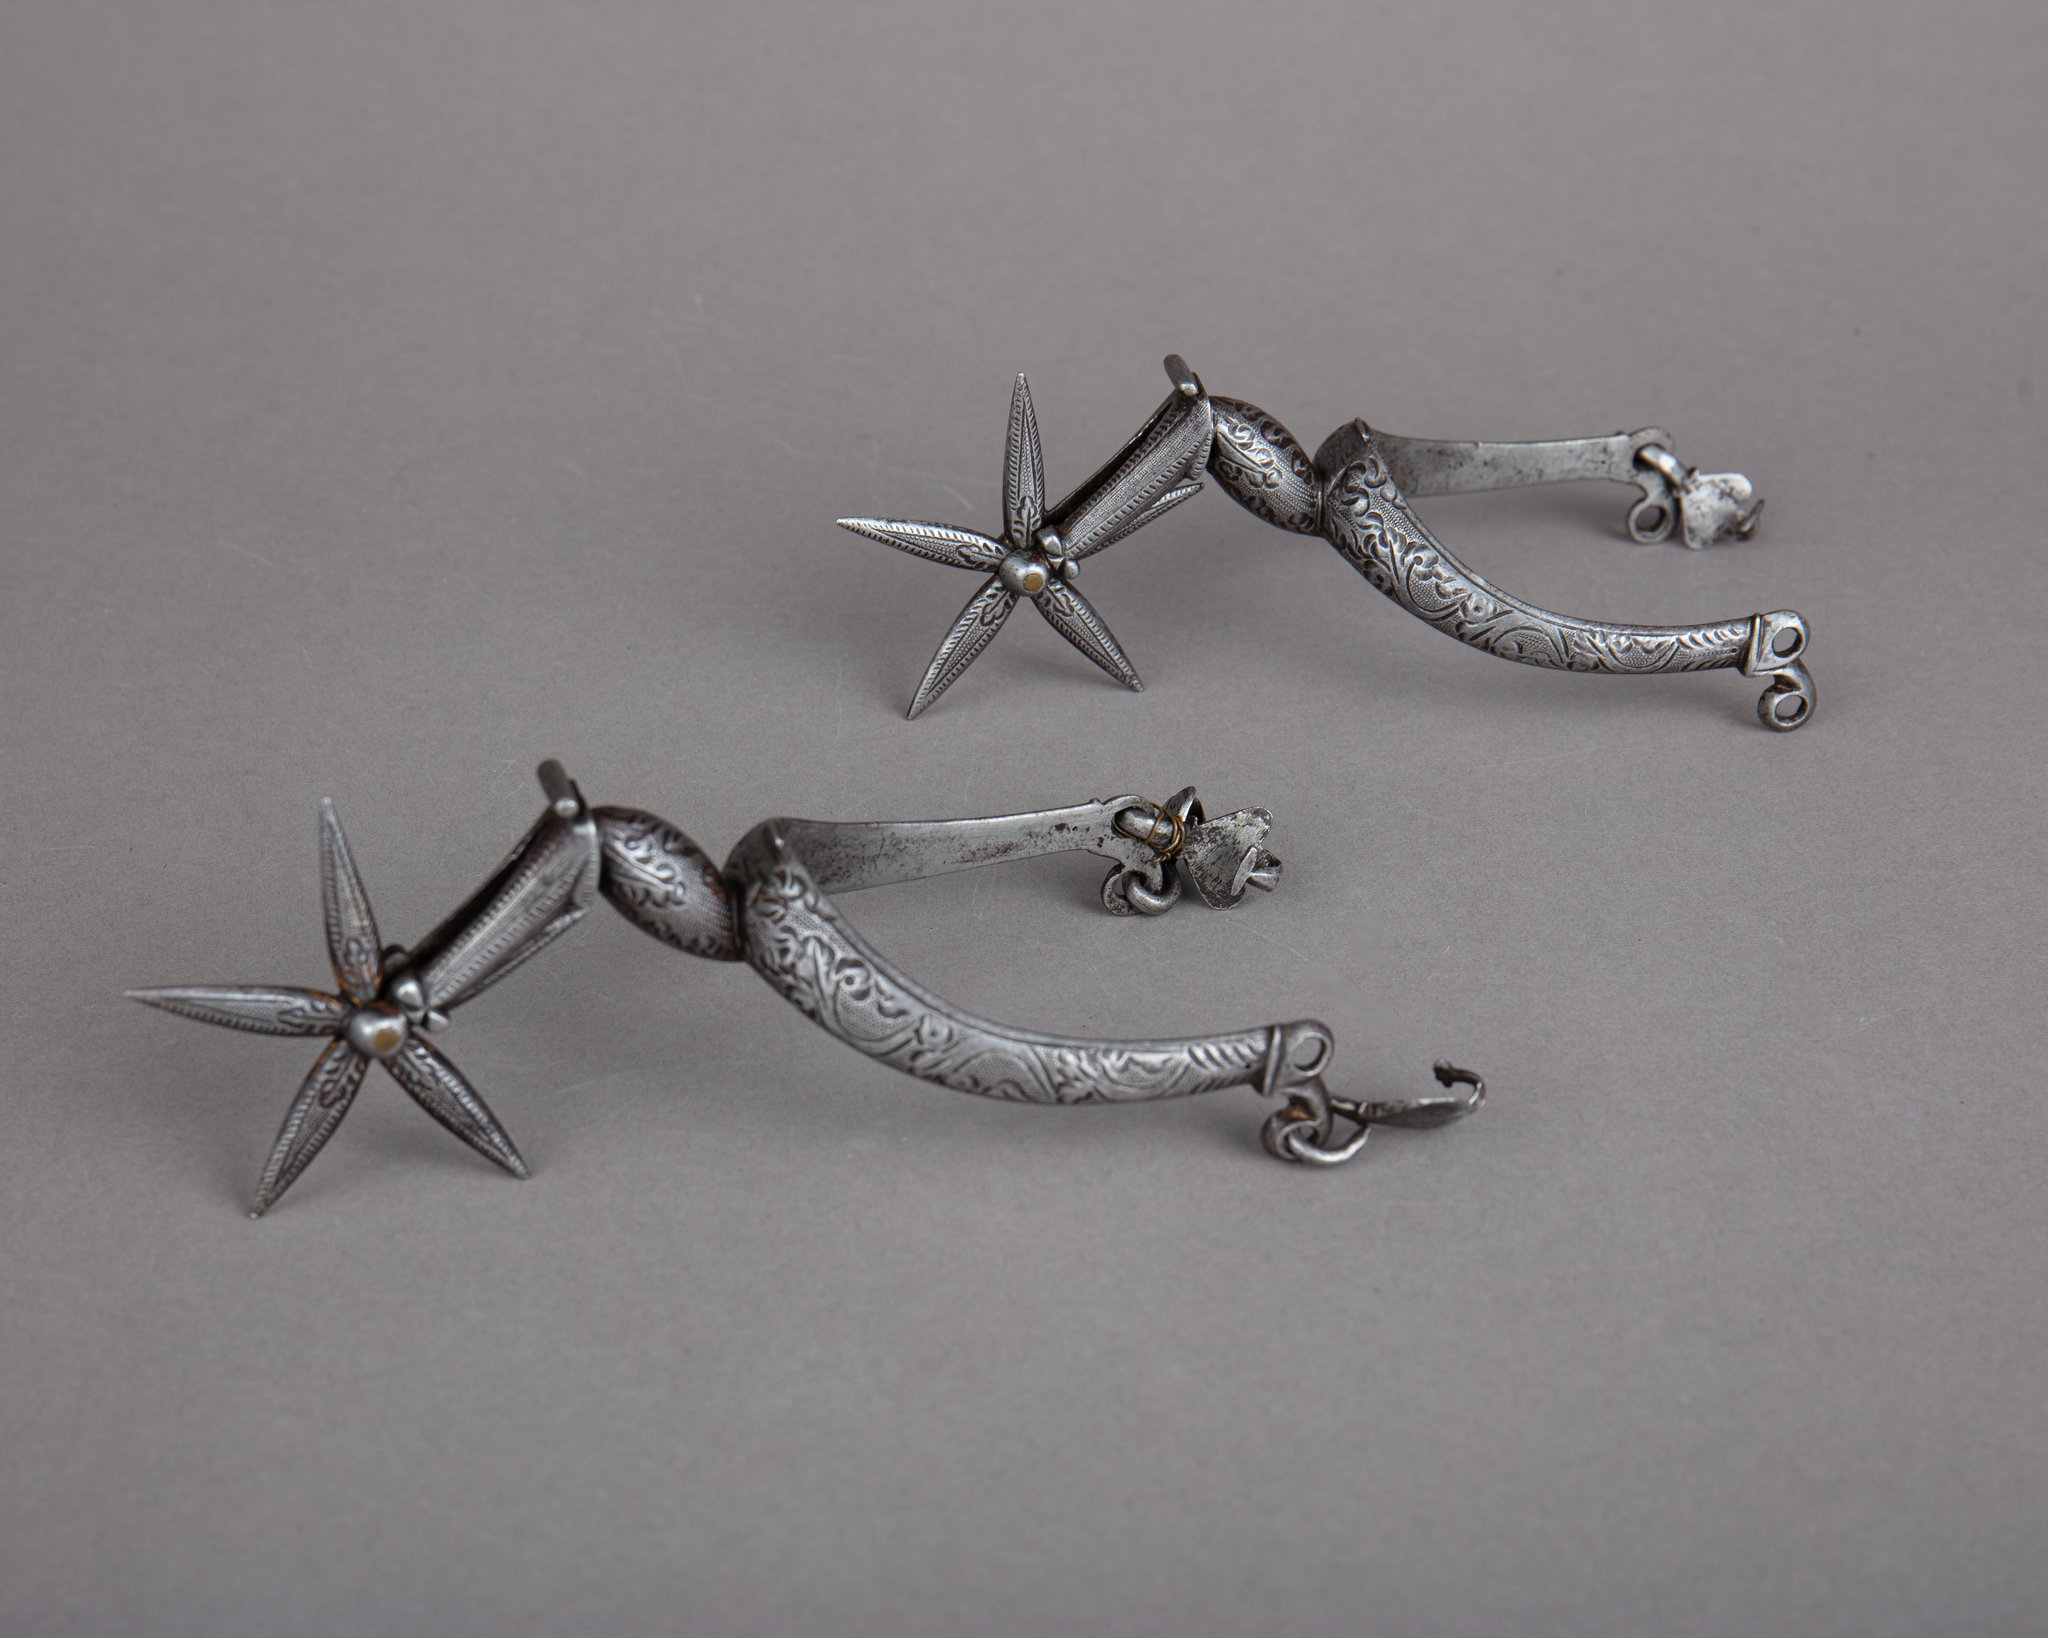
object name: spur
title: Pair of Rowel Spurs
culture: german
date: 1630-1660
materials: gold, metal alloy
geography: germany